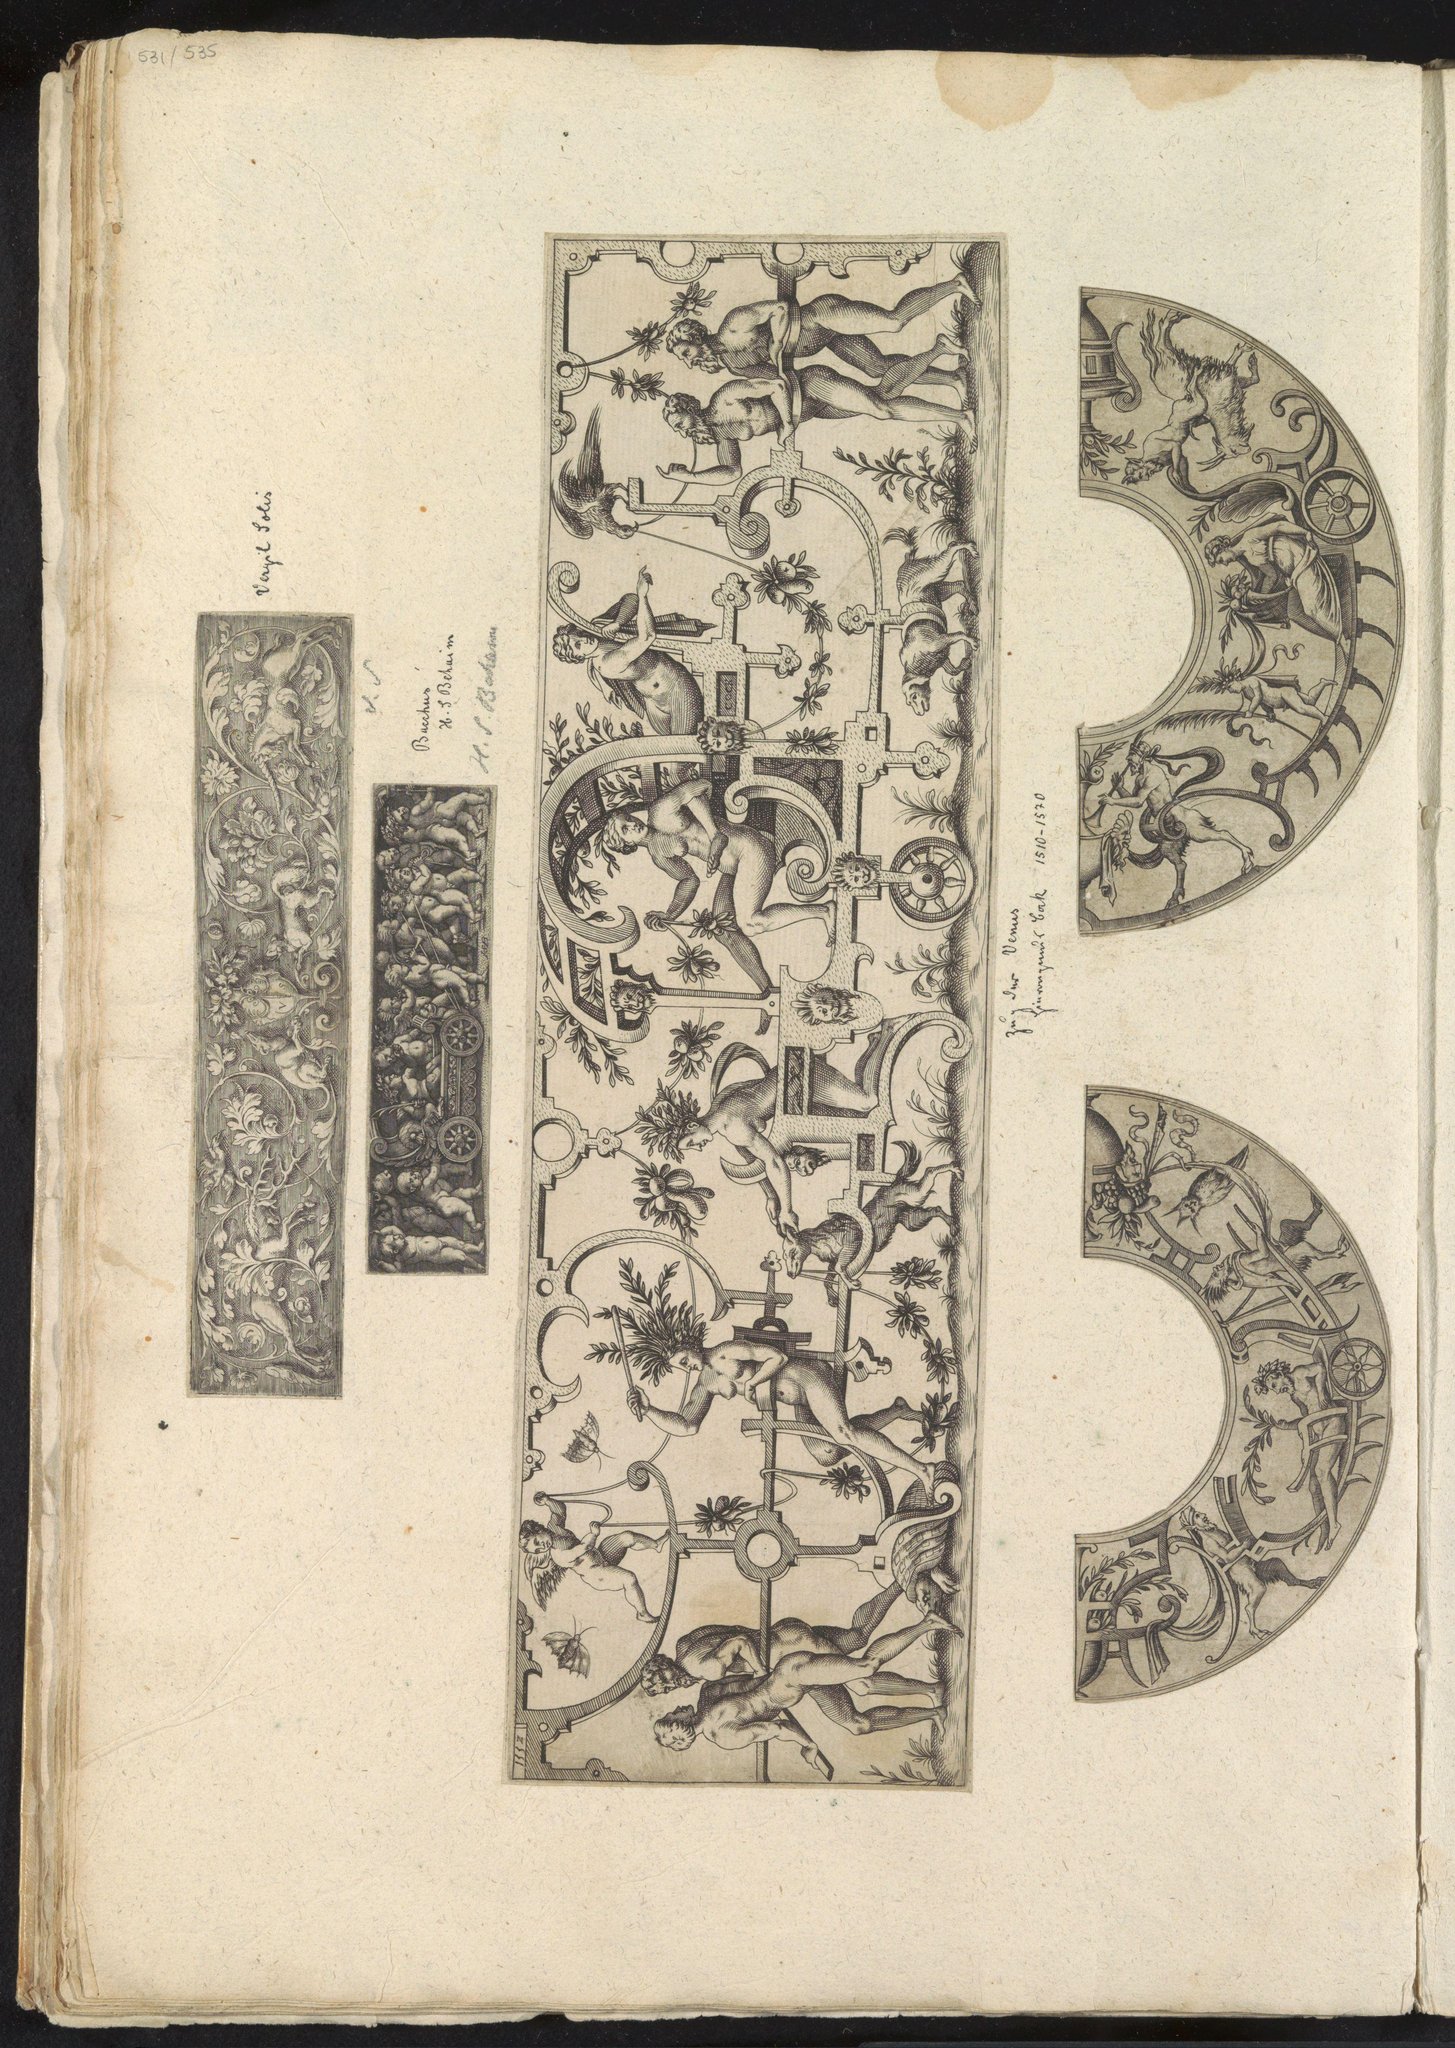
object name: ornament print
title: Albumblad met vijf ornamentprenten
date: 1500-1599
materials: paper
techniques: engraving, etching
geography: netherlands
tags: ornaments ~ art, (other) ornaments derived from objects (with name), satyr(s) (in general), cupids: 'amores', 'amoretti', 'putti'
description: Albumblad met vijf uitgeknipte ornamentprenten: twee friezen, Venus op een triomfwagen getrokken door bosnimfen en twee halve cirkels met saters en wagens.